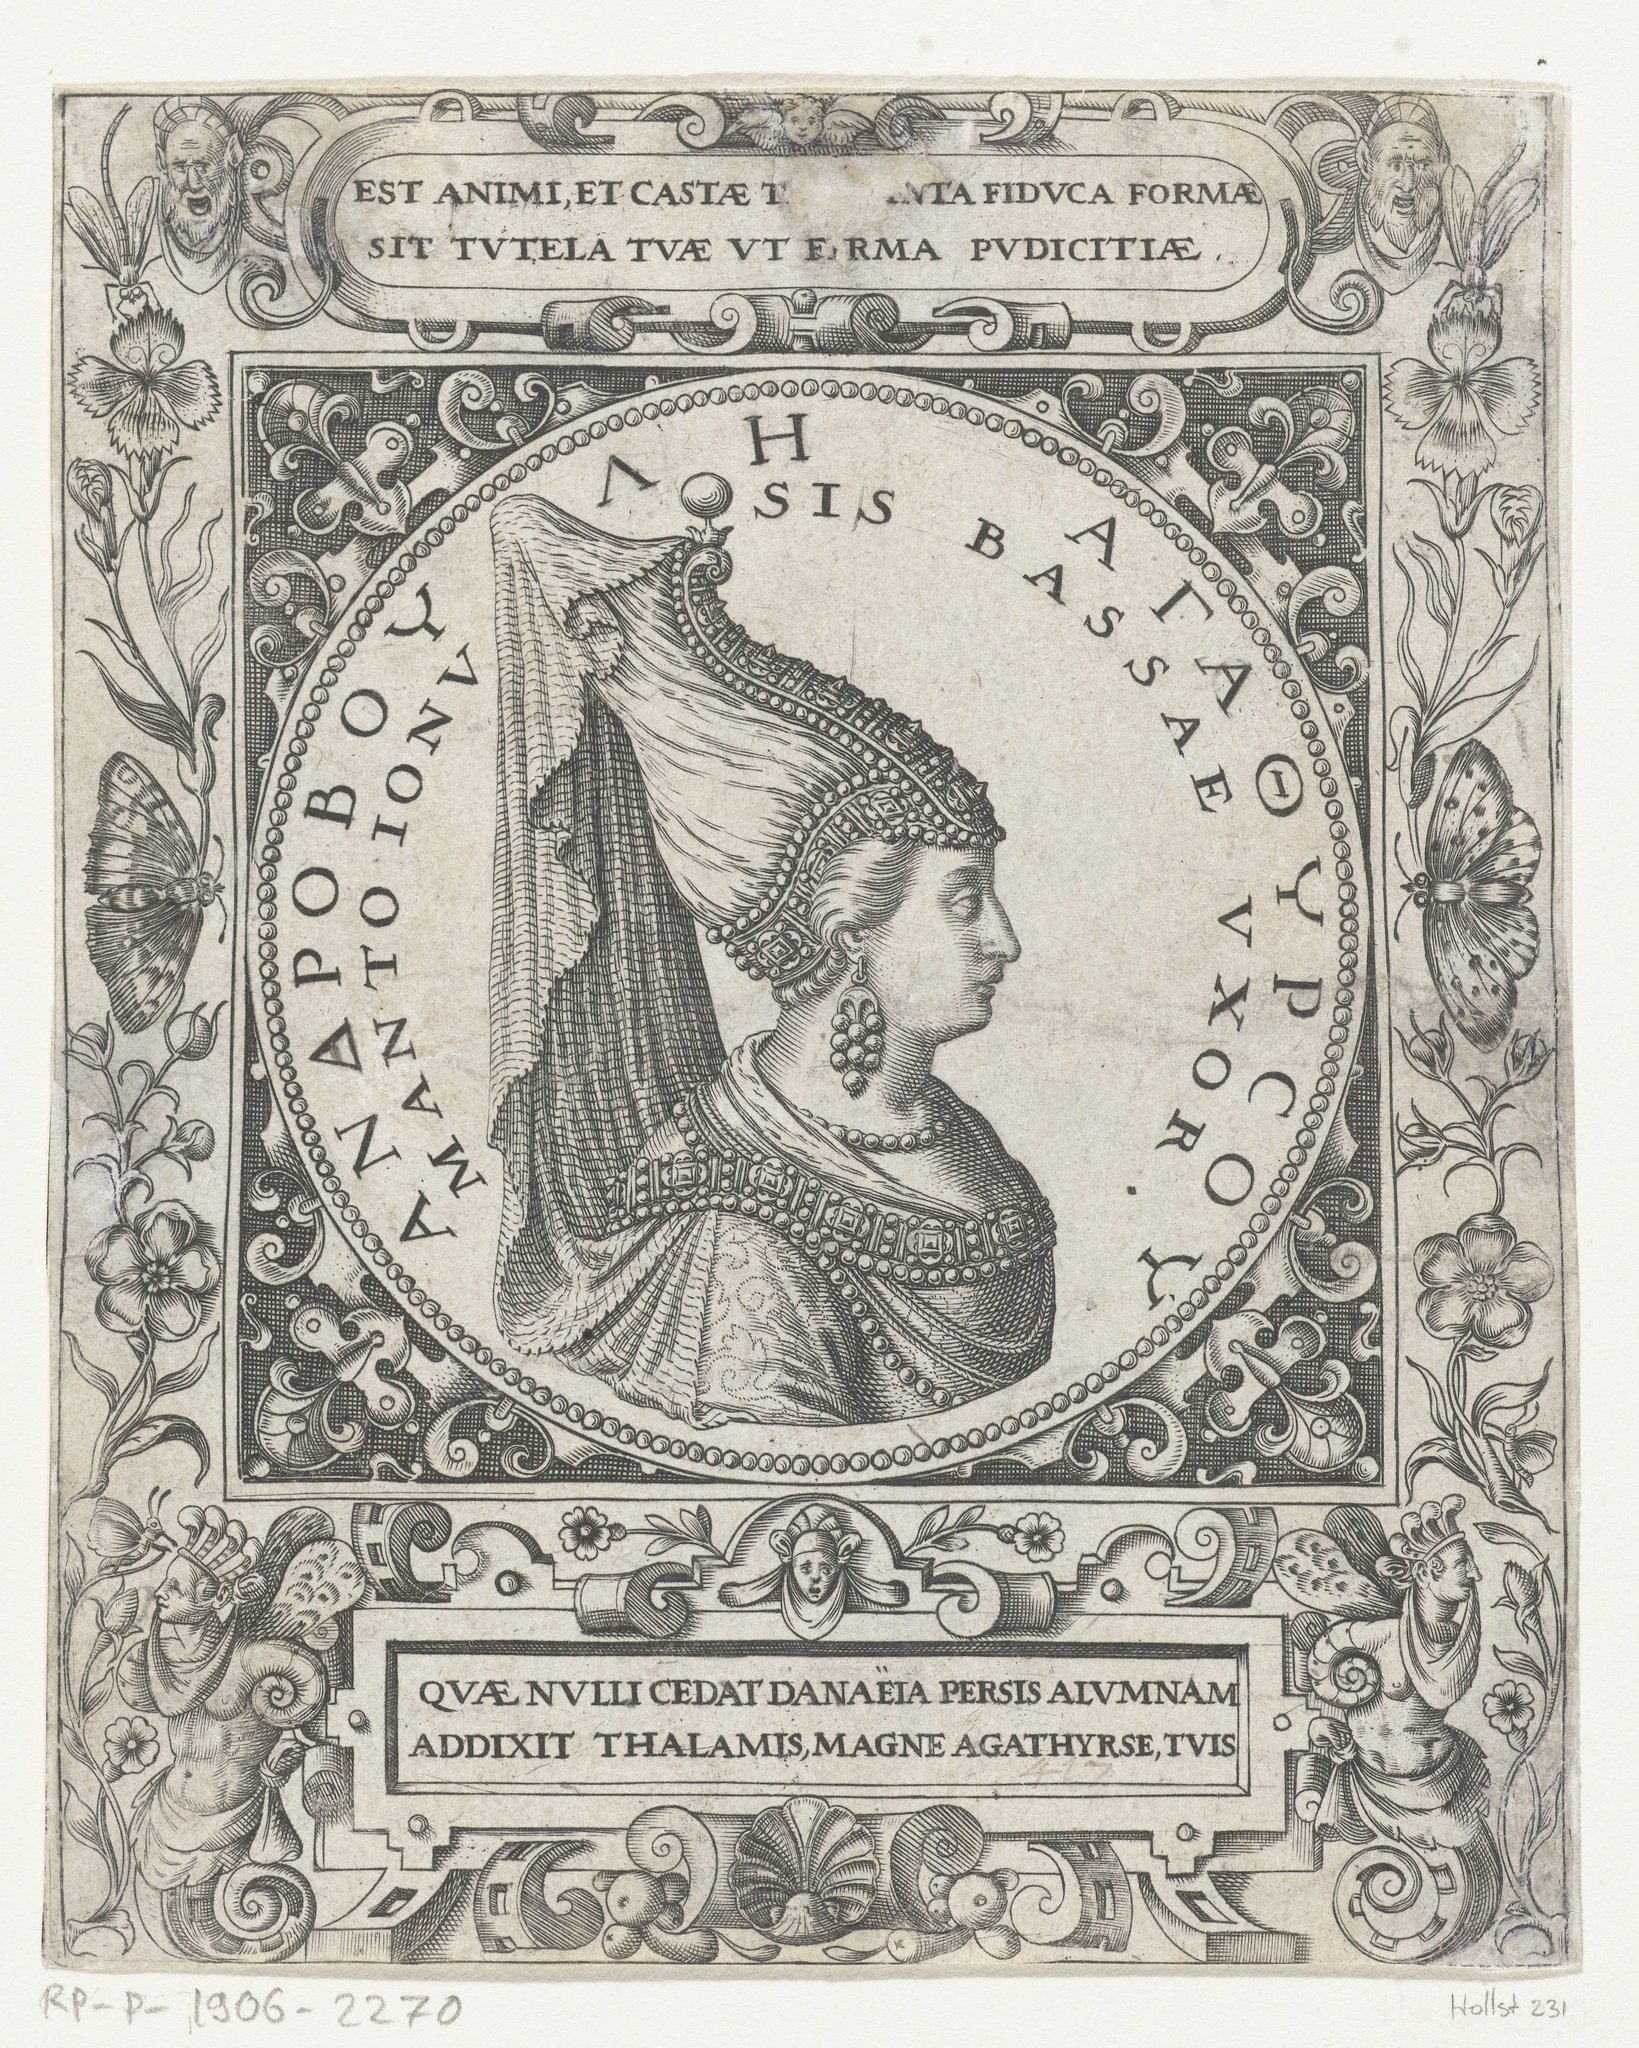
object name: book illustration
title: Manto Ionusis Bassae Uxor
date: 1596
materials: paper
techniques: engraving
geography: frankfurt am main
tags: islam, mohammedanism, ruler, sovereign - bb - female ruler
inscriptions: collector's mark: Lugt 2228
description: Afkomstig uit: J.J. Boissard, Vitae et icones svltanorvm tvrcicorum, principvm persarvm aliorumq illustrium heroum heroinarumq ab Osmane usq ad Mahometem II. Frankfurt am Main: T. de Bry, 1596.